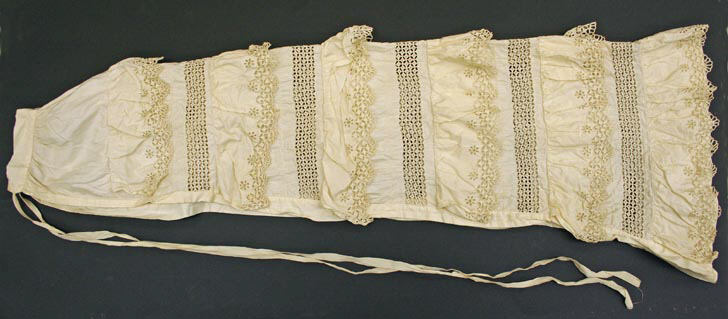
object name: textile panel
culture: american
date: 1801-1900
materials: cotton